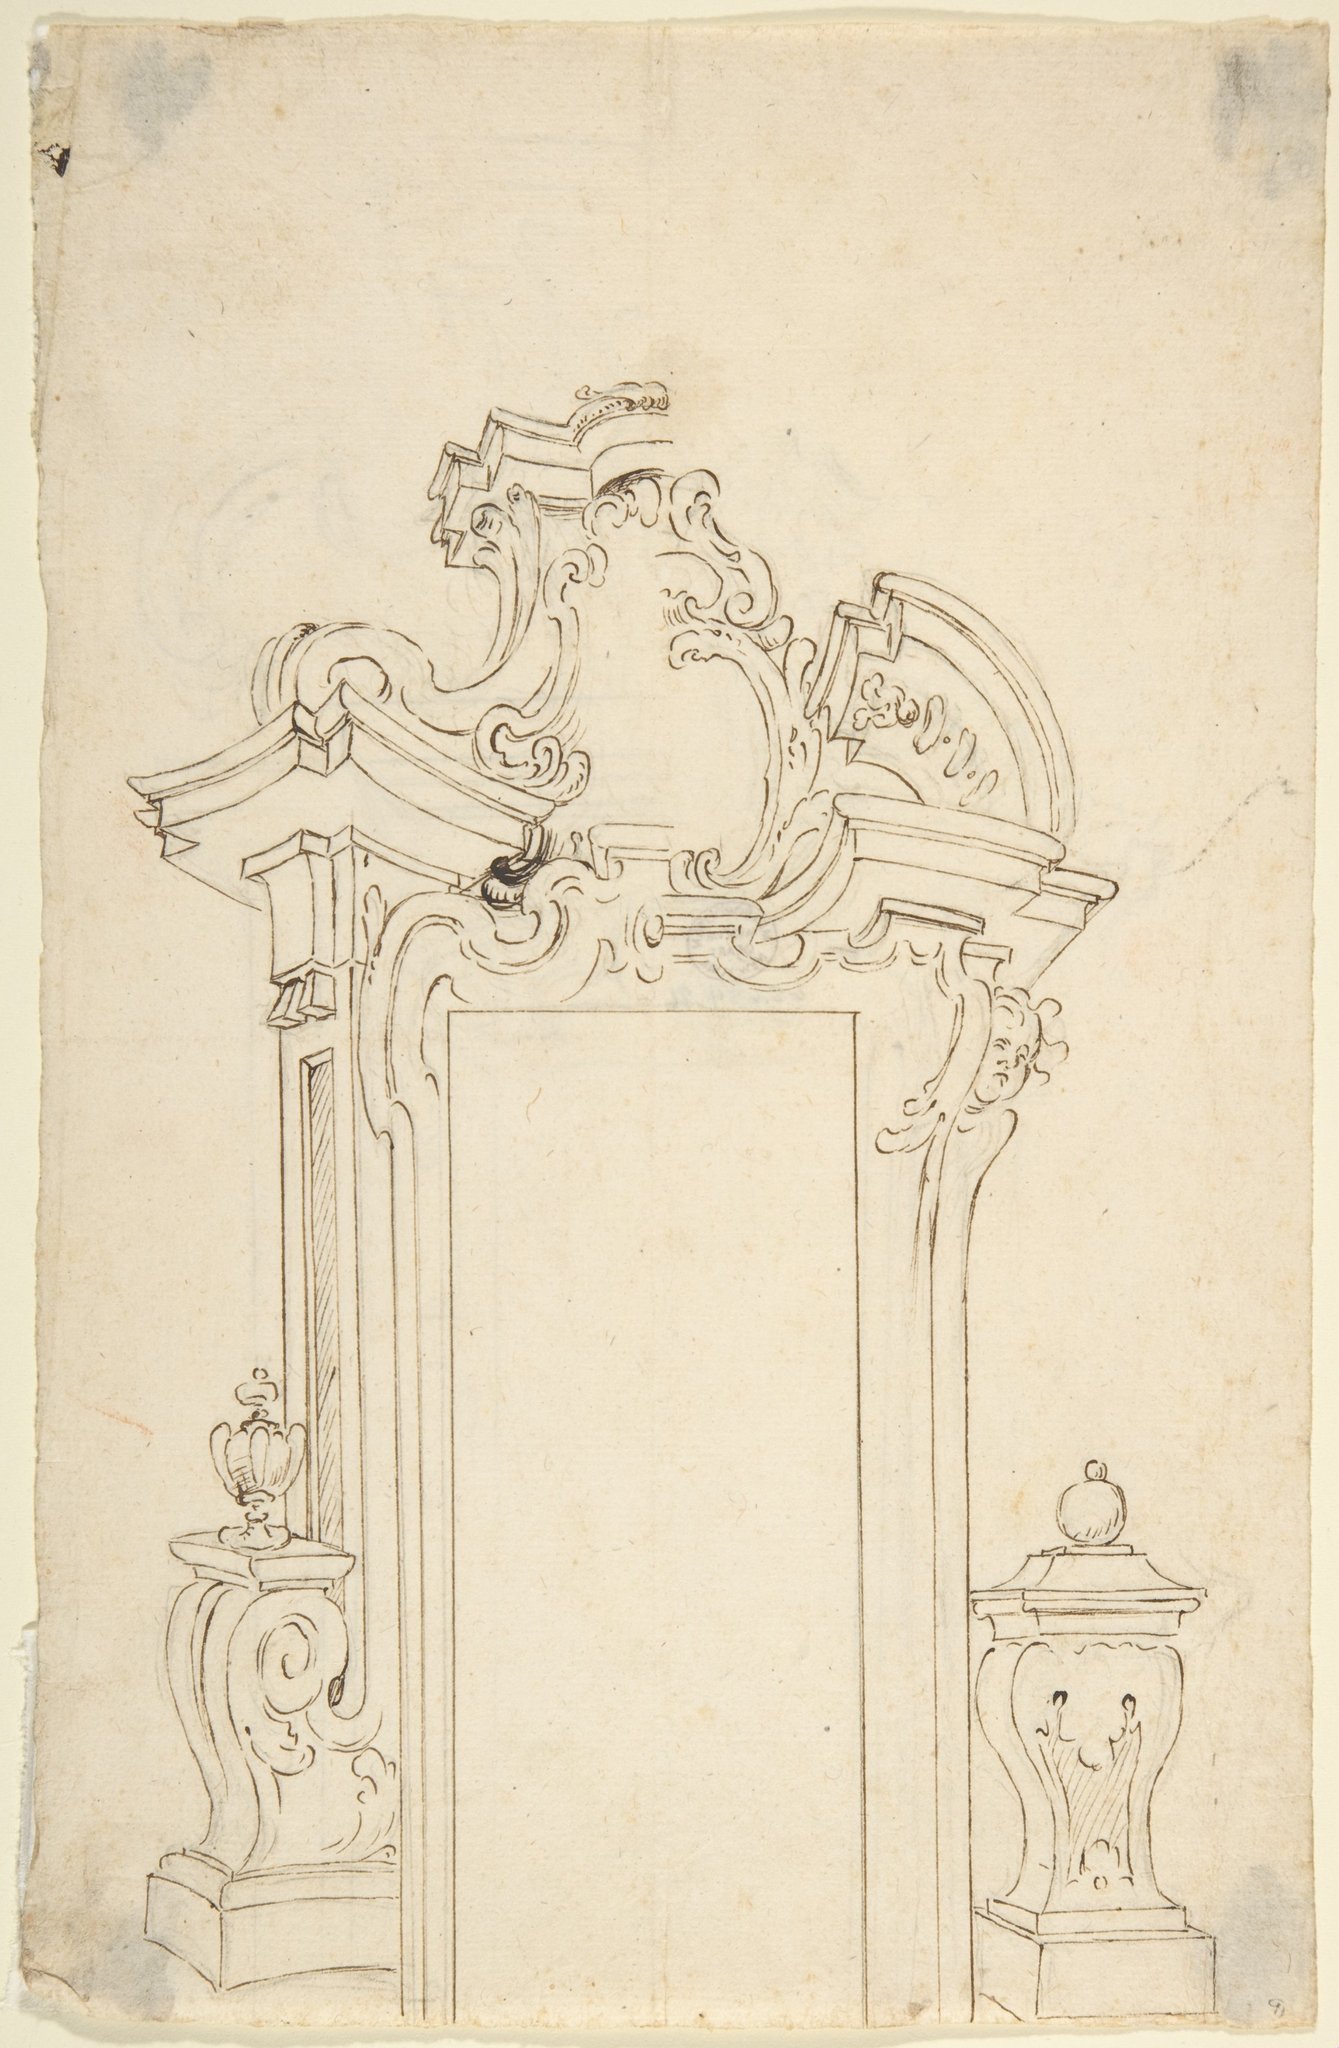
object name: drawing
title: Two Alternate Designs for a Door Frame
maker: anonymous, italian, piedmontese, 18th century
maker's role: artist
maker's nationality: italian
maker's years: 1700-1800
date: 1700-1780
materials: graphite, ink, drawing material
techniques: pen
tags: architecture